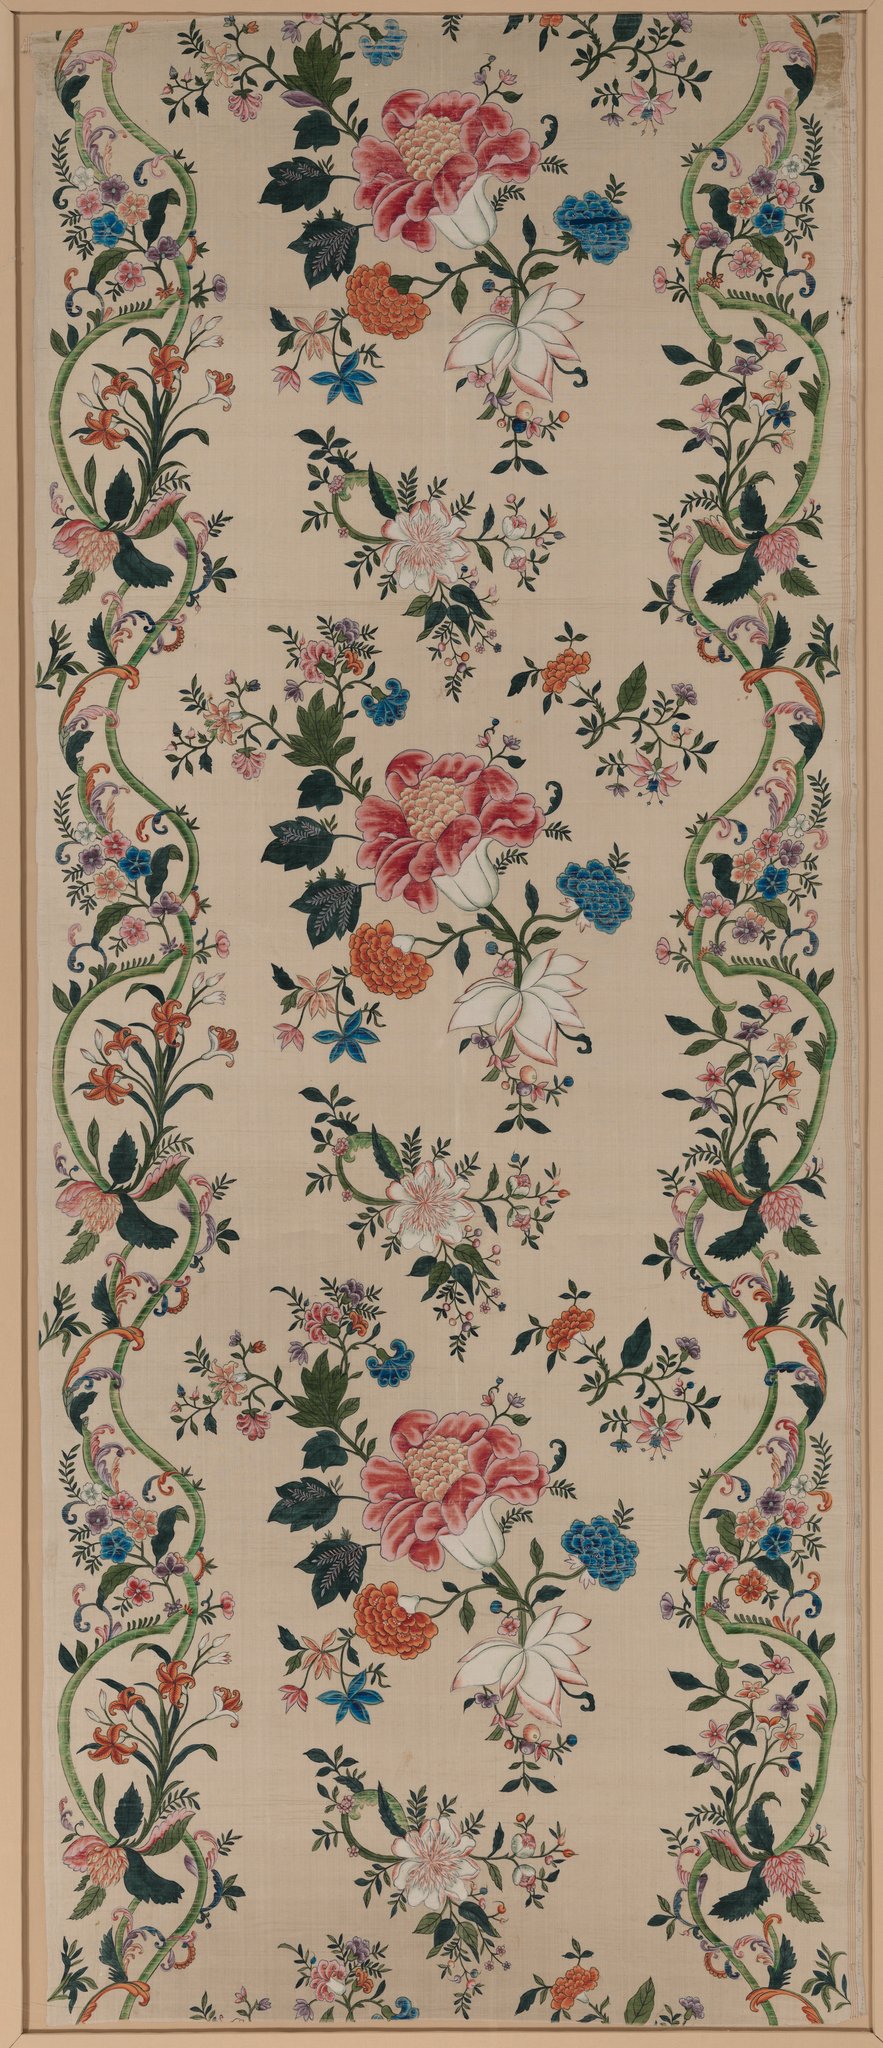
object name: panel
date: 1701-1733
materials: silk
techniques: painting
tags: flowers